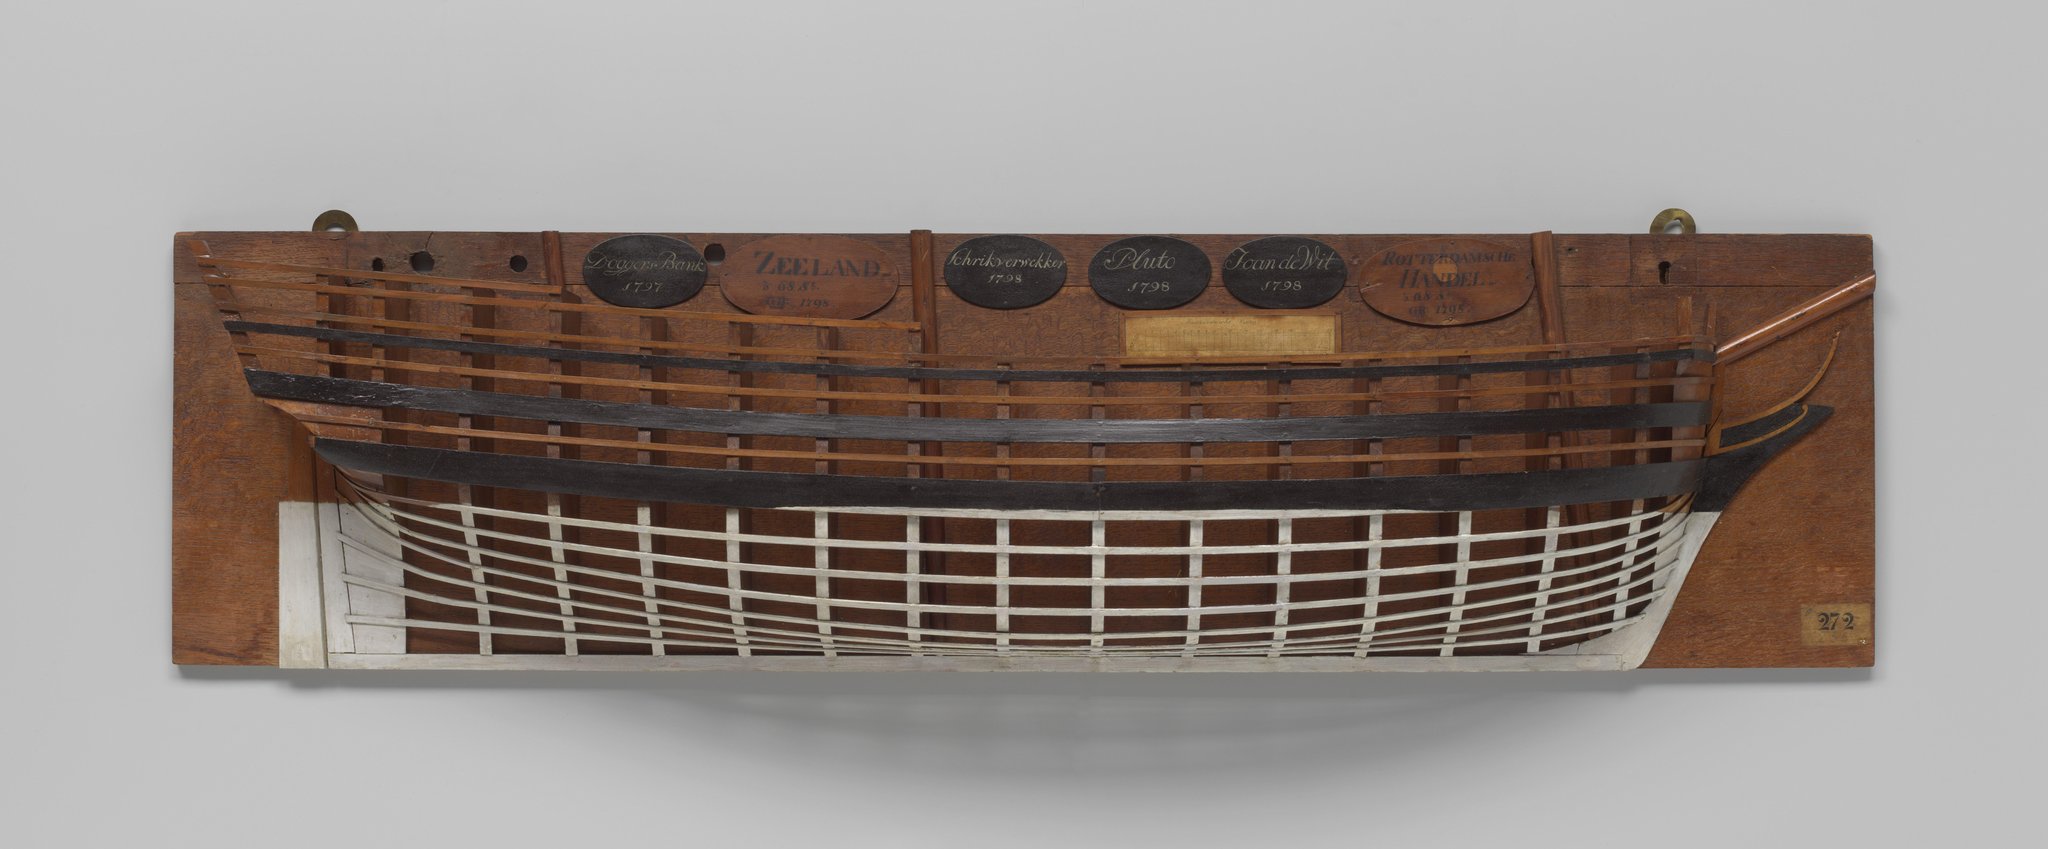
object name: builder's model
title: Half Model of a 68-Gun Ship of the Line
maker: Anonymous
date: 1797-1798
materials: wood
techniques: polychromy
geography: netherlands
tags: neptunus (schip), zeeland (schip), joan de wit (schip), doggersbank (schip)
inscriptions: label, bottom right: ‘272’ former inventory label, inscription, top, from left to right, on six oval wooden labels (some painted black): ‘Doggers Bank / 1797 // ZEELAND / à 68 St. / GB: 1798. // Schrikverwekker / 1798 // Pluto / 1798 // Joan de Wit / 1798 // ROTTERDAMSCHE / HANDEL. / à 68 St. / GB: 1798.’, scale, top centre: paper scale in Amsterdam feet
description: P. Glavimans Jz. heeft drie 68-ers van 180 voet volgens dit model in Rotterdam gebouwd: de Doggersbank (1797-1839), herdoopt Zeeland in 1814, de Joan de Wit (1798-1817) en de Neptunus (1798). Een Neptunus van 68 stukken is in de lijsten niet terug te vinden, maar volgens één bron is zij door P. Glavimans Jz. in 1798 te Rotterdam gebouwd, in 1805 herdoopt Zeeland en in 1808 gesloopt.